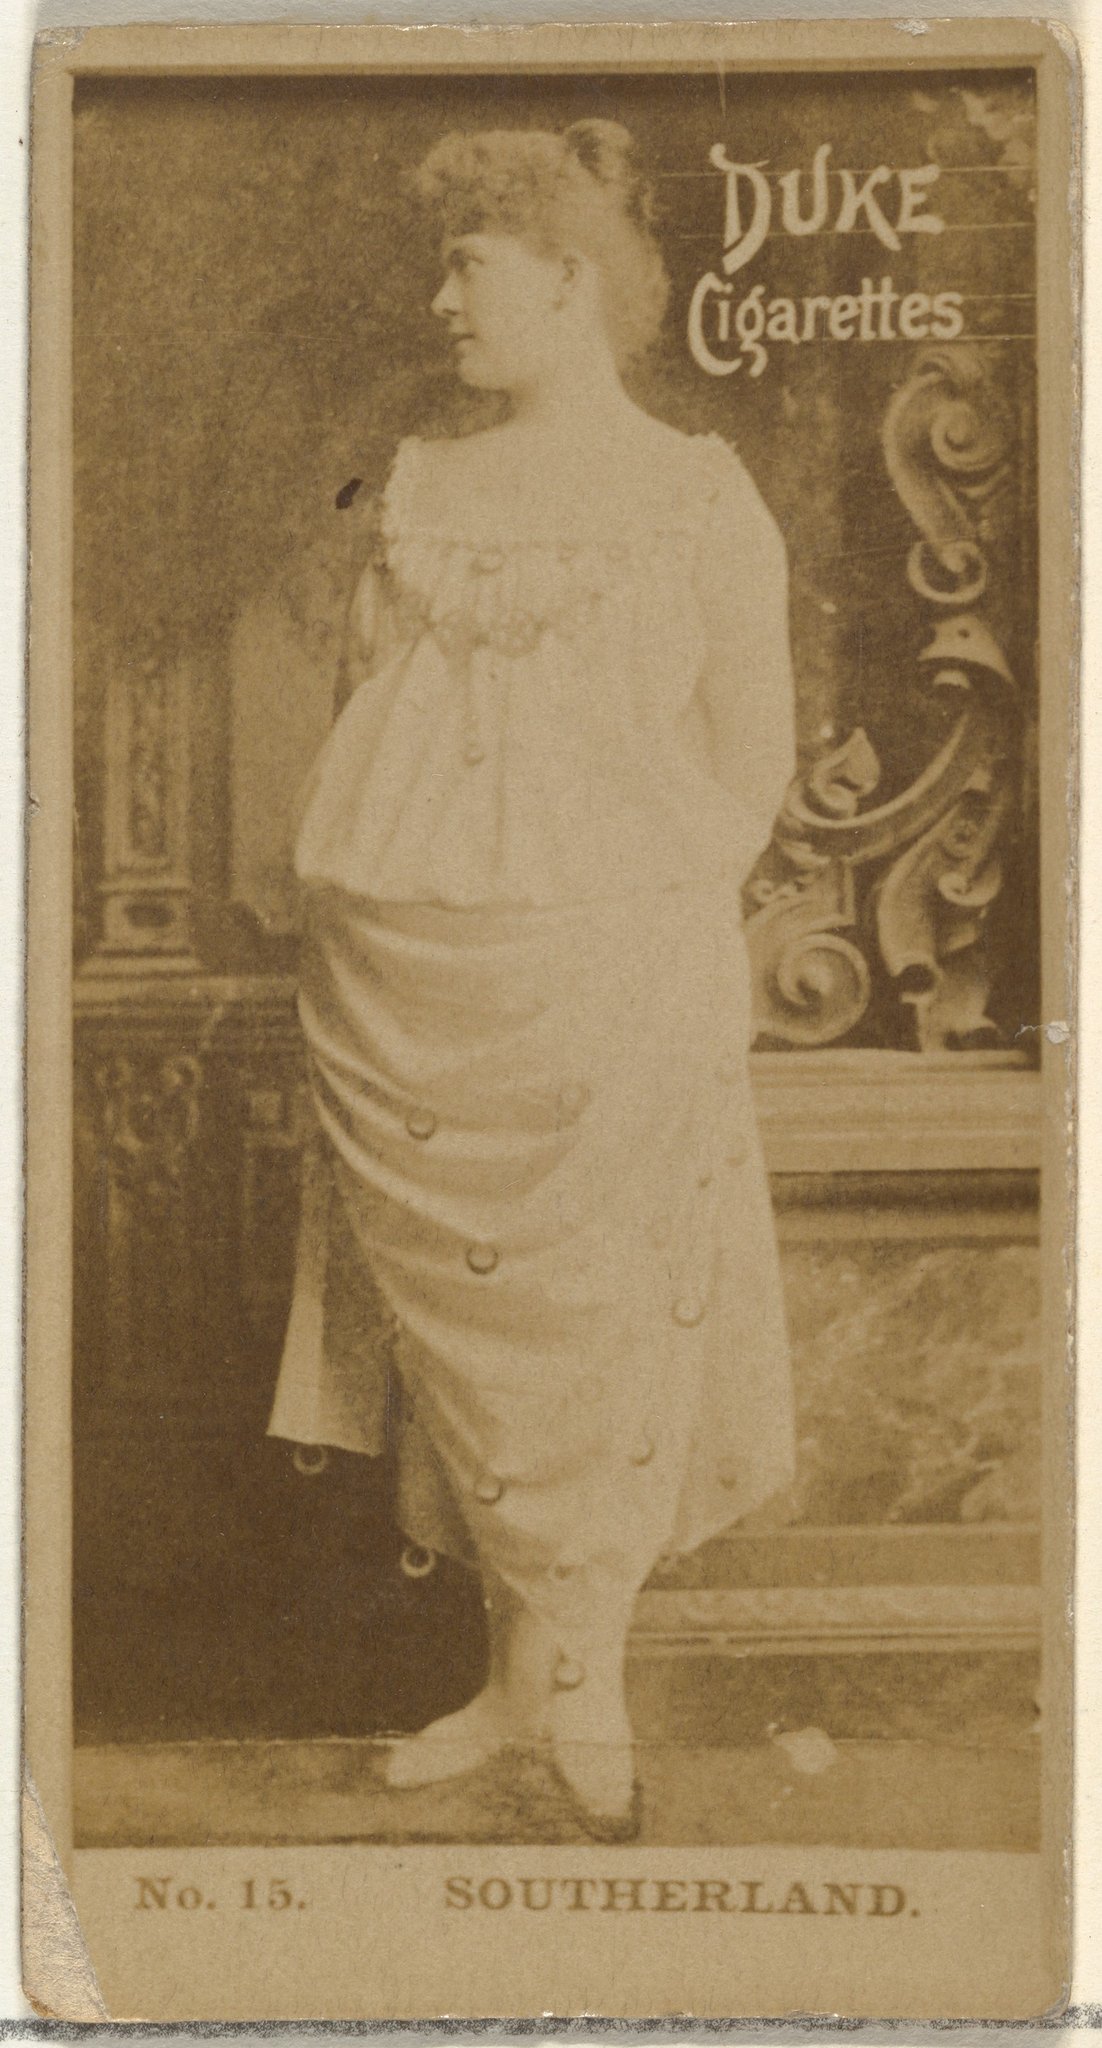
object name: photograph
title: Card Number 15, Miss Southerland, from the Actors and Actresses series (N145-6) issued by Duke Sons & Co. to promote Duke Cigarettes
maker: w. duke, sons & co.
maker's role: publisher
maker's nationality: american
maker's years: 1870-1920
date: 1880-1889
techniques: albumen silver print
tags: women,actresses